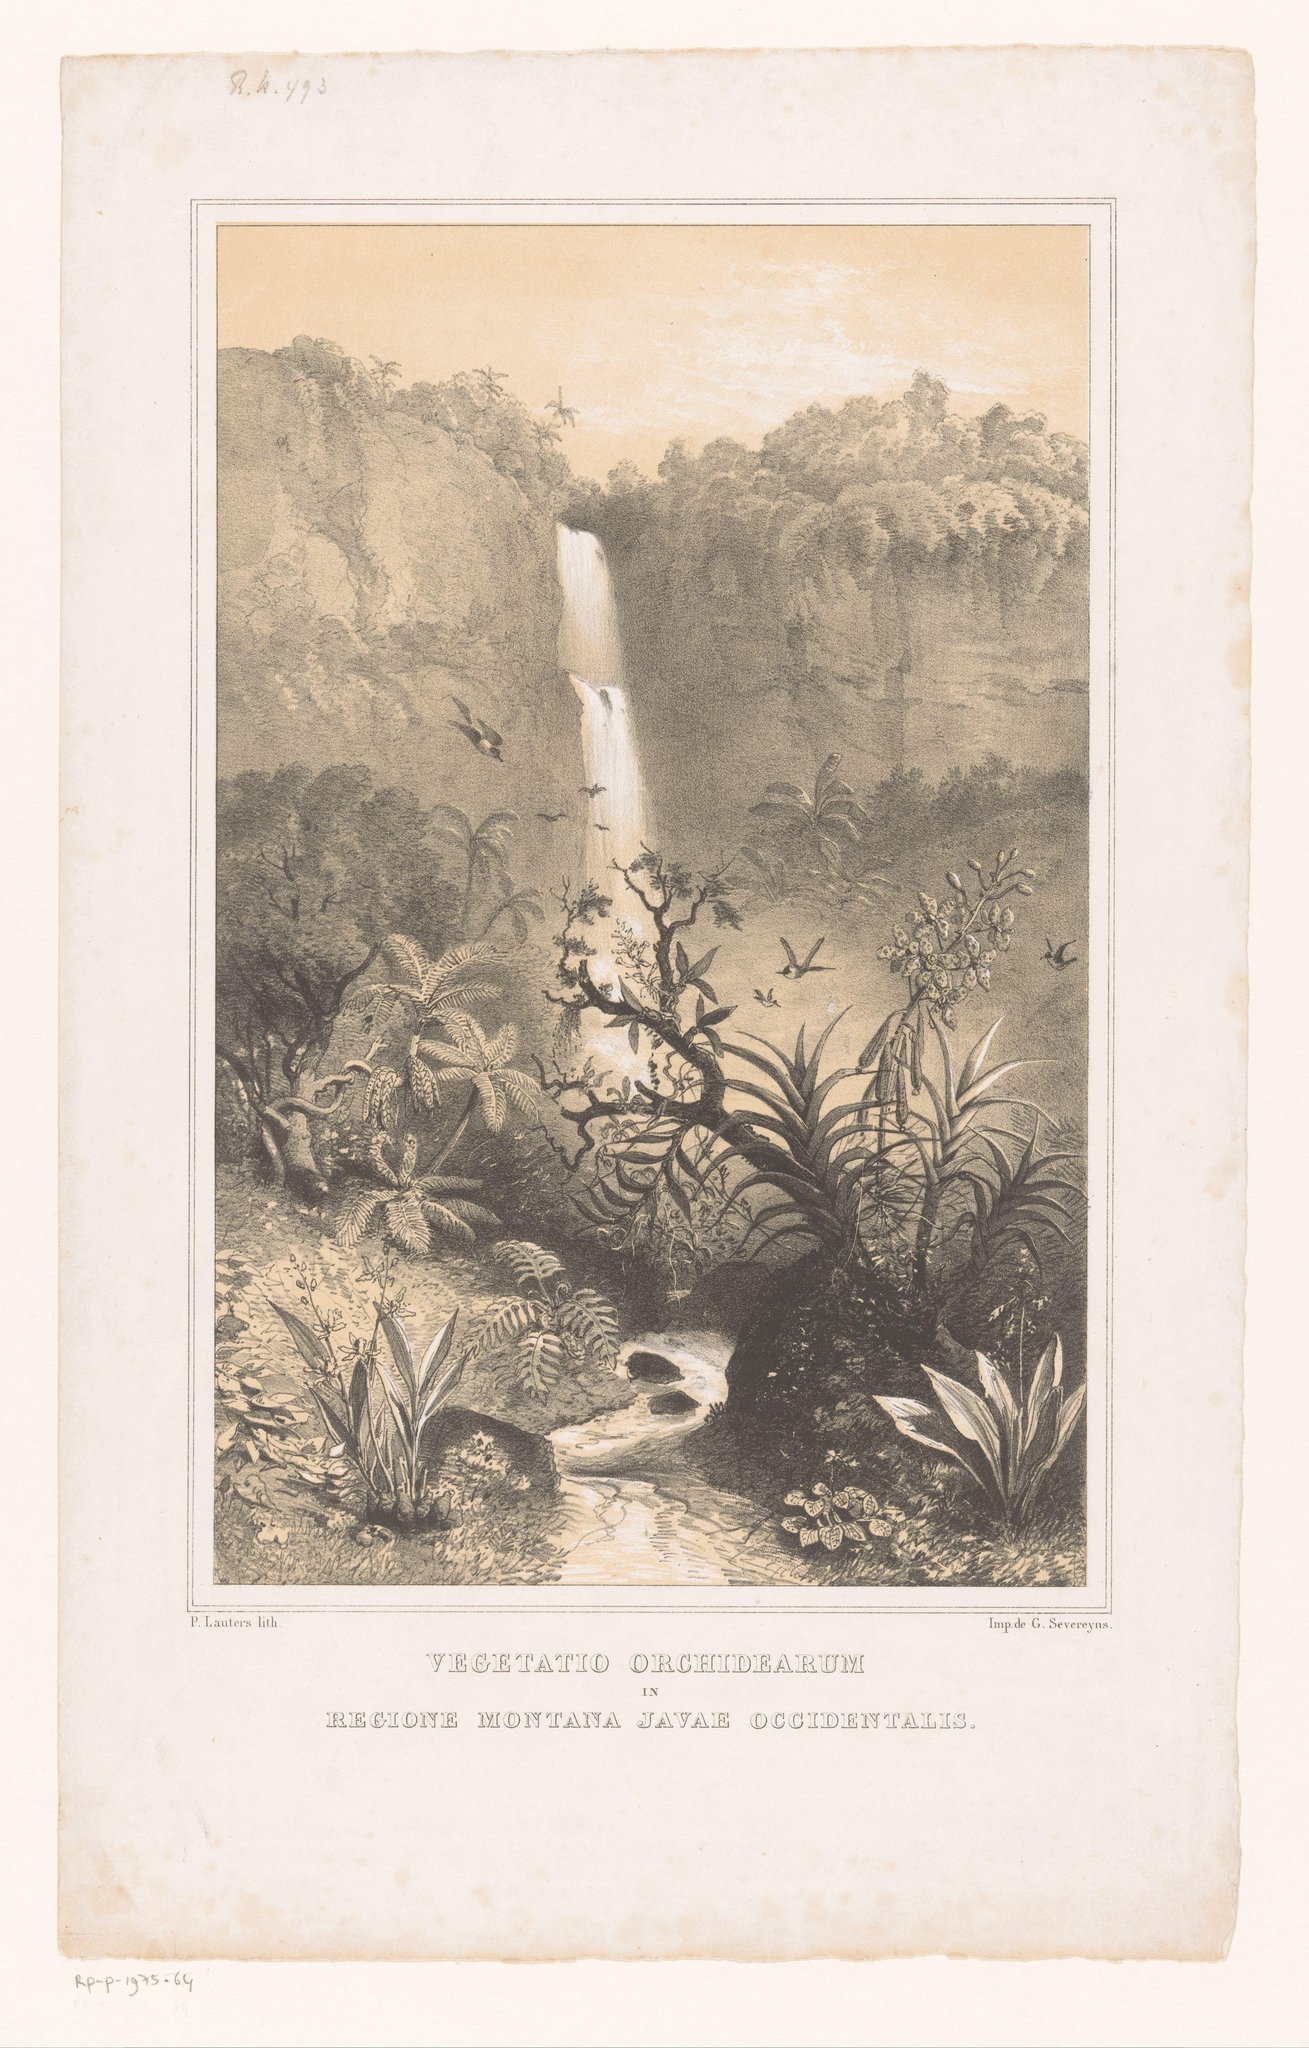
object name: print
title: Vegetatio orchidearum in regione Montana Javae occidentalis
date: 1816-1875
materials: paper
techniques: tone lithography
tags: flowers: orchid, waterfall, java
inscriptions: stamp: ‘'s Rijks Herbarium No 899.108-493’, collector's mark: Lugt 2228